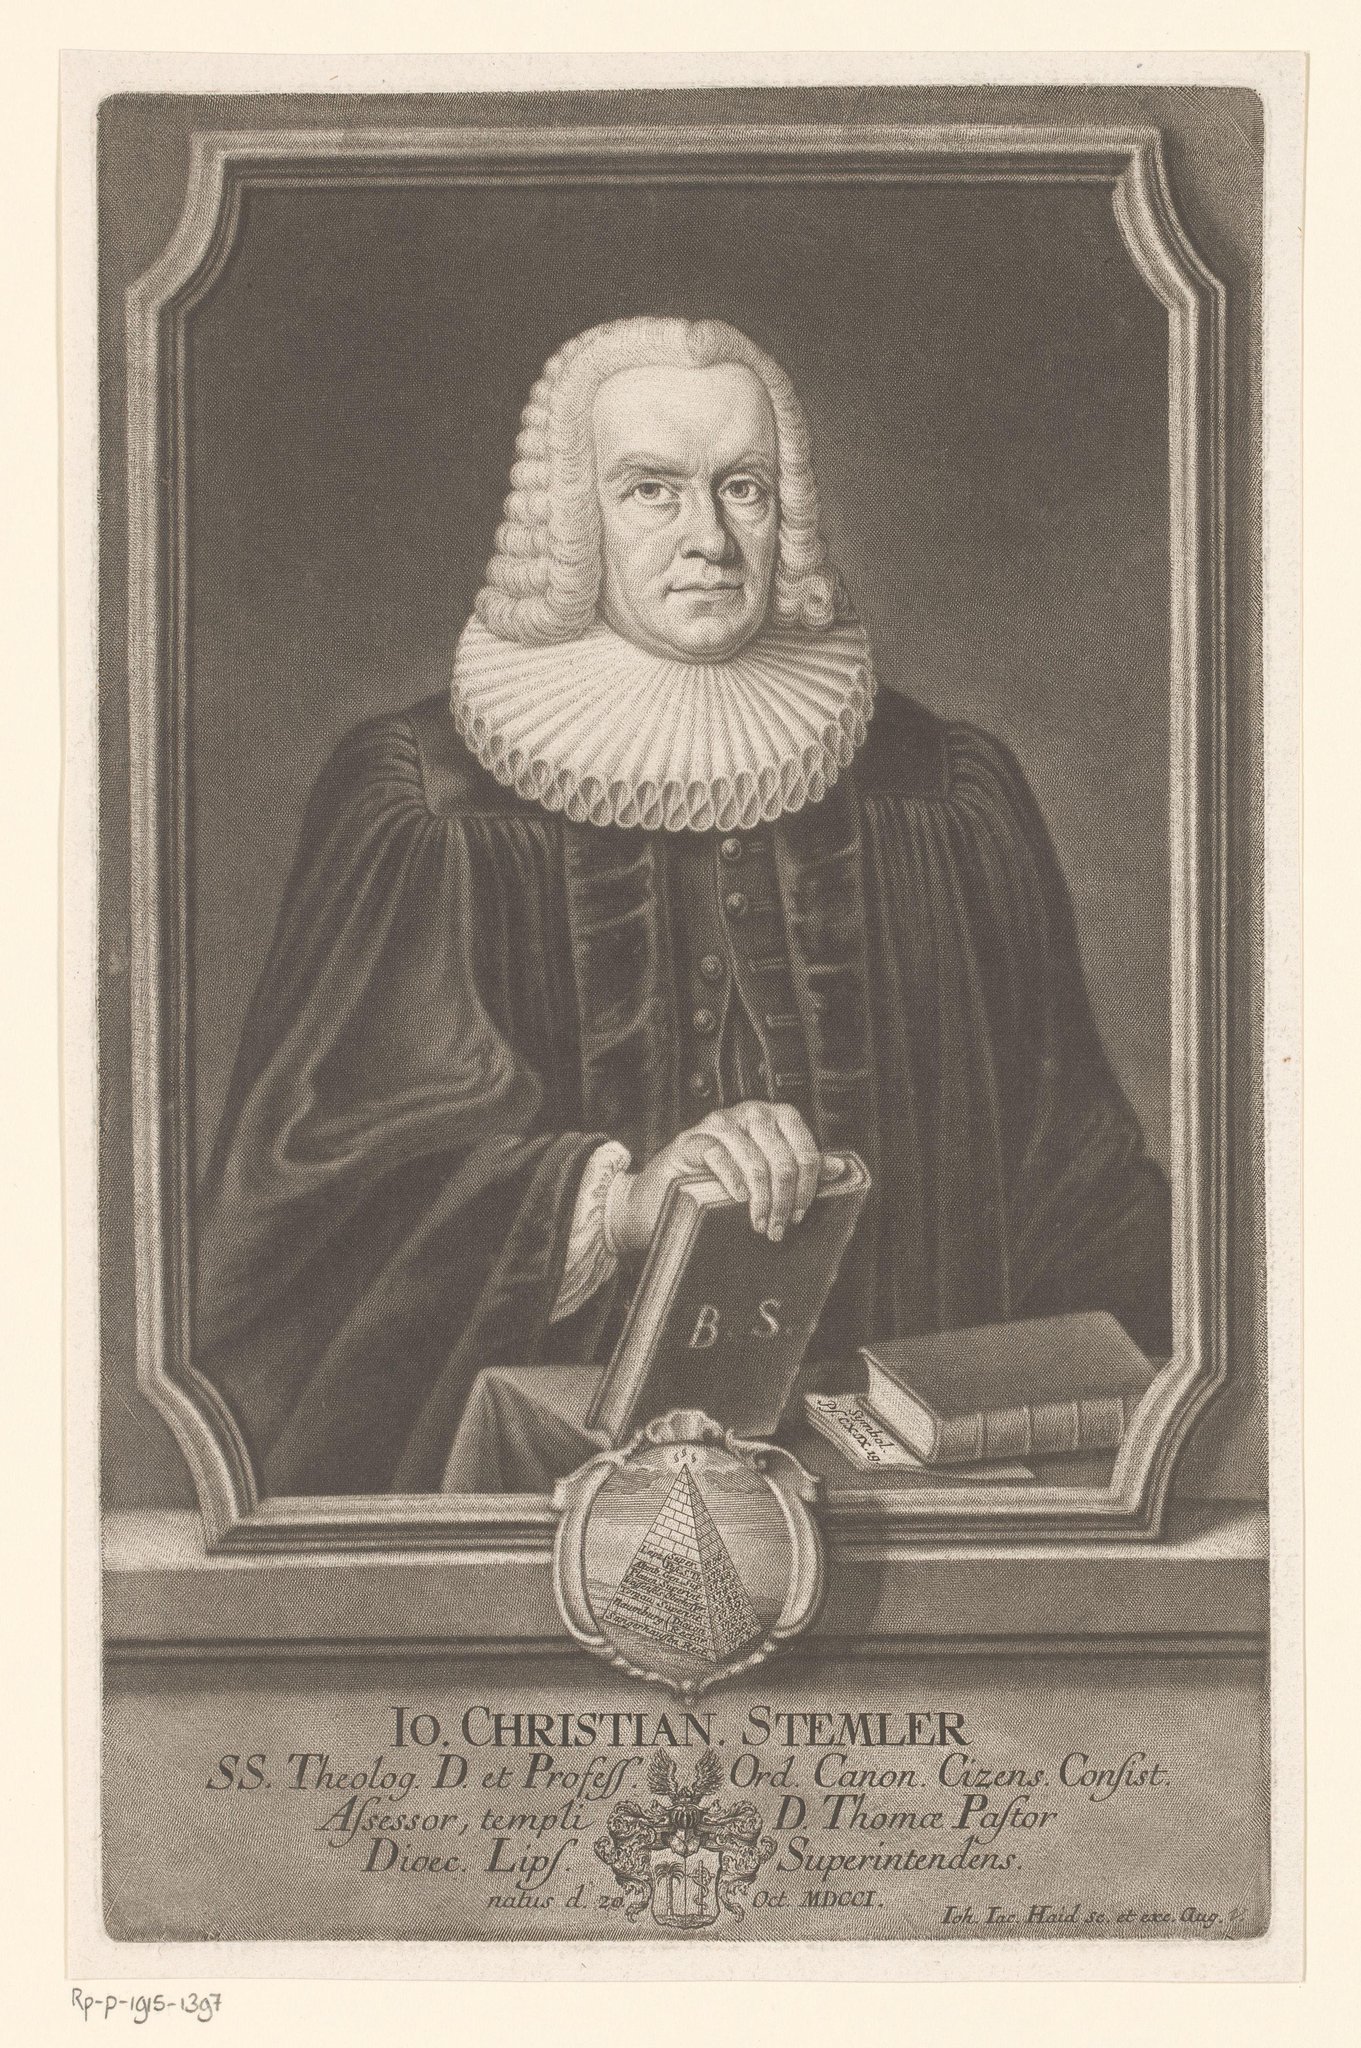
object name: print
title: Portret van Johann Christian Stemler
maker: johann jacob haid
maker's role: print maker, publisher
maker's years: 1704-1767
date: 1757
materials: paper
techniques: etching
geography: augsburg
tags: historical persons, book, abstract ideas and concepts (+ emblematical representation of concept), armorial bearing, heraldry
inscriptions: collector's mark: Lugt 2228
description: Prent gebruikt voor: Haid, Johann Jacob. Neue Sammlung von Bildnissen gelehrter (...) noch lebender Männer. Augsburg: Johann Jacob Haid, 1757.